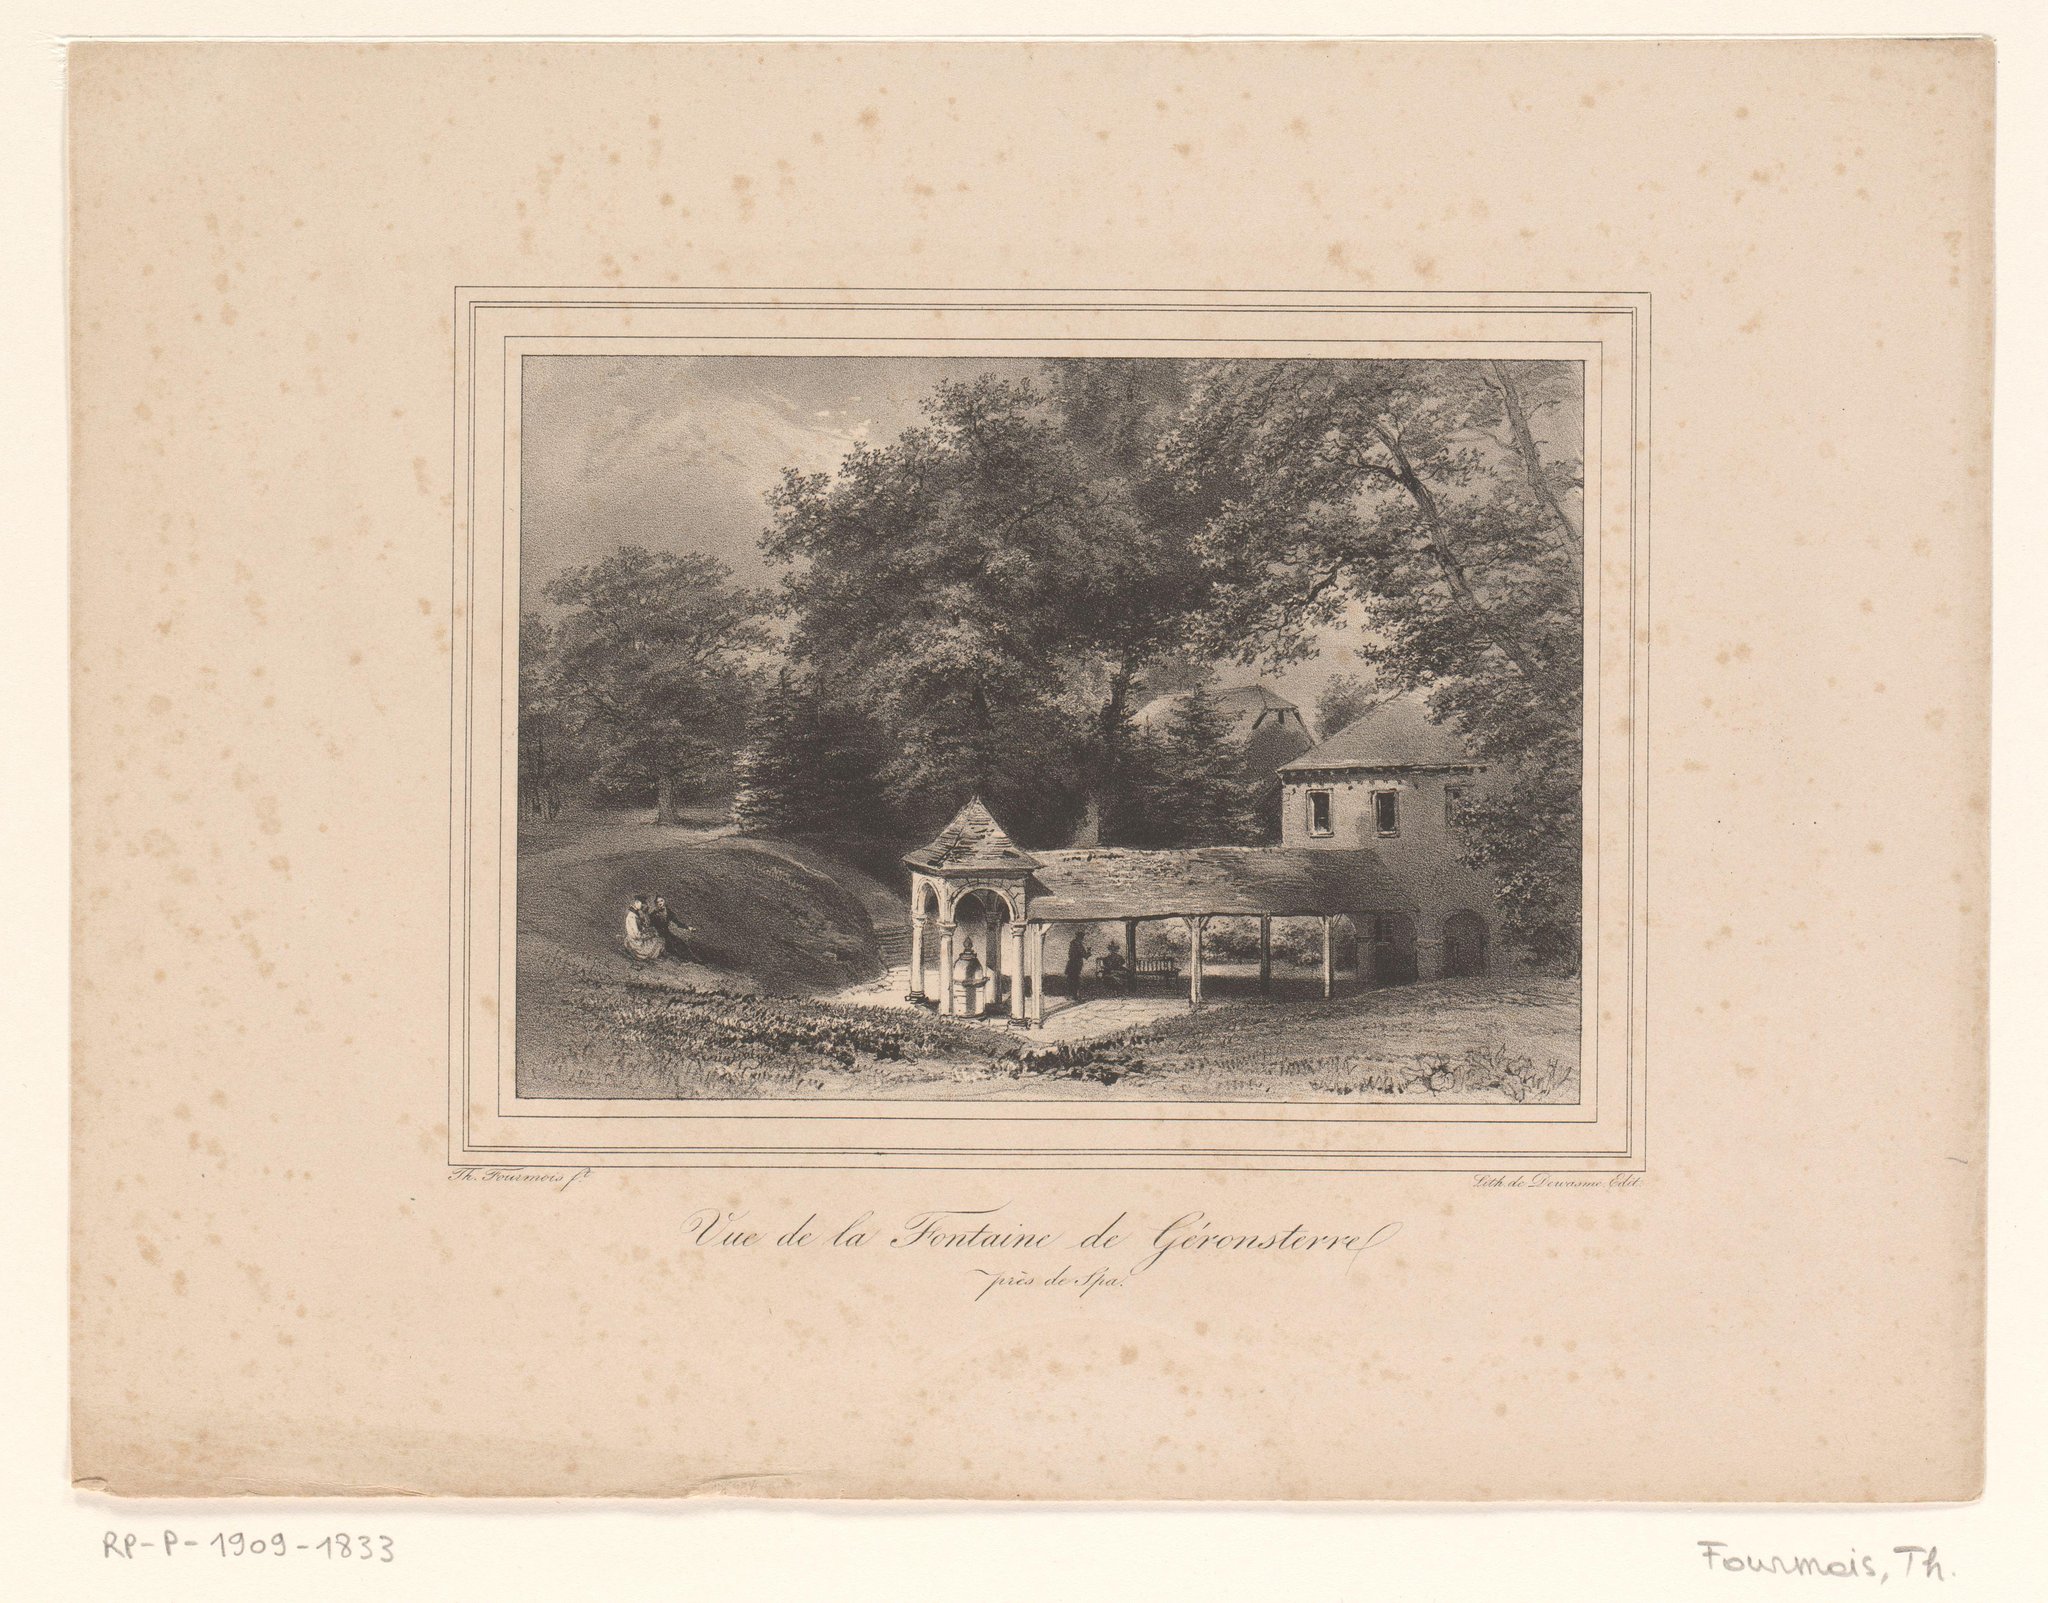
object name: print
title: Vues de Spa et de ses environs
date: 1833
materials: paper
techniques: lithograph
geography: brussels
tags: mineral water, city-view, and landscape with man-made constructions (+ city(-scape) with figures, staffage)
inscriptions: collector's mark: Lugt 2228